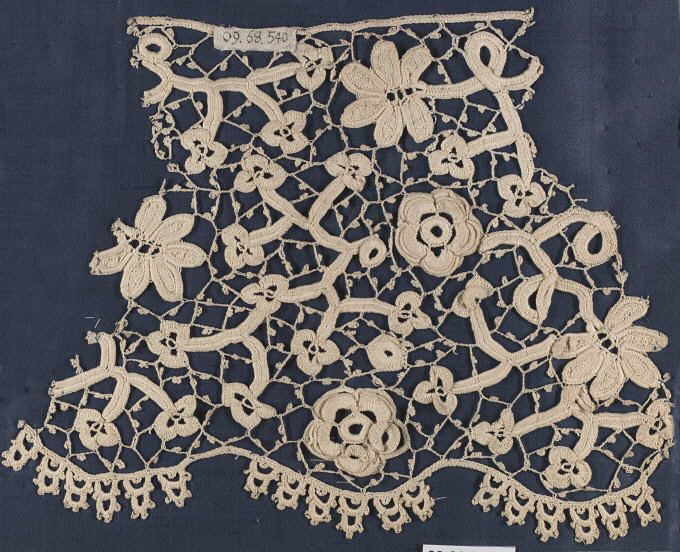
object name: specimen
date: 1801-1900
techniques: crochet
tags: flowers